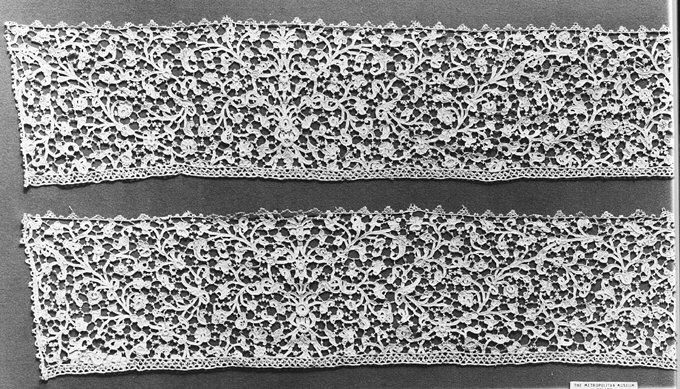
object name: fragment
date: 1601-1700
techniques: lace